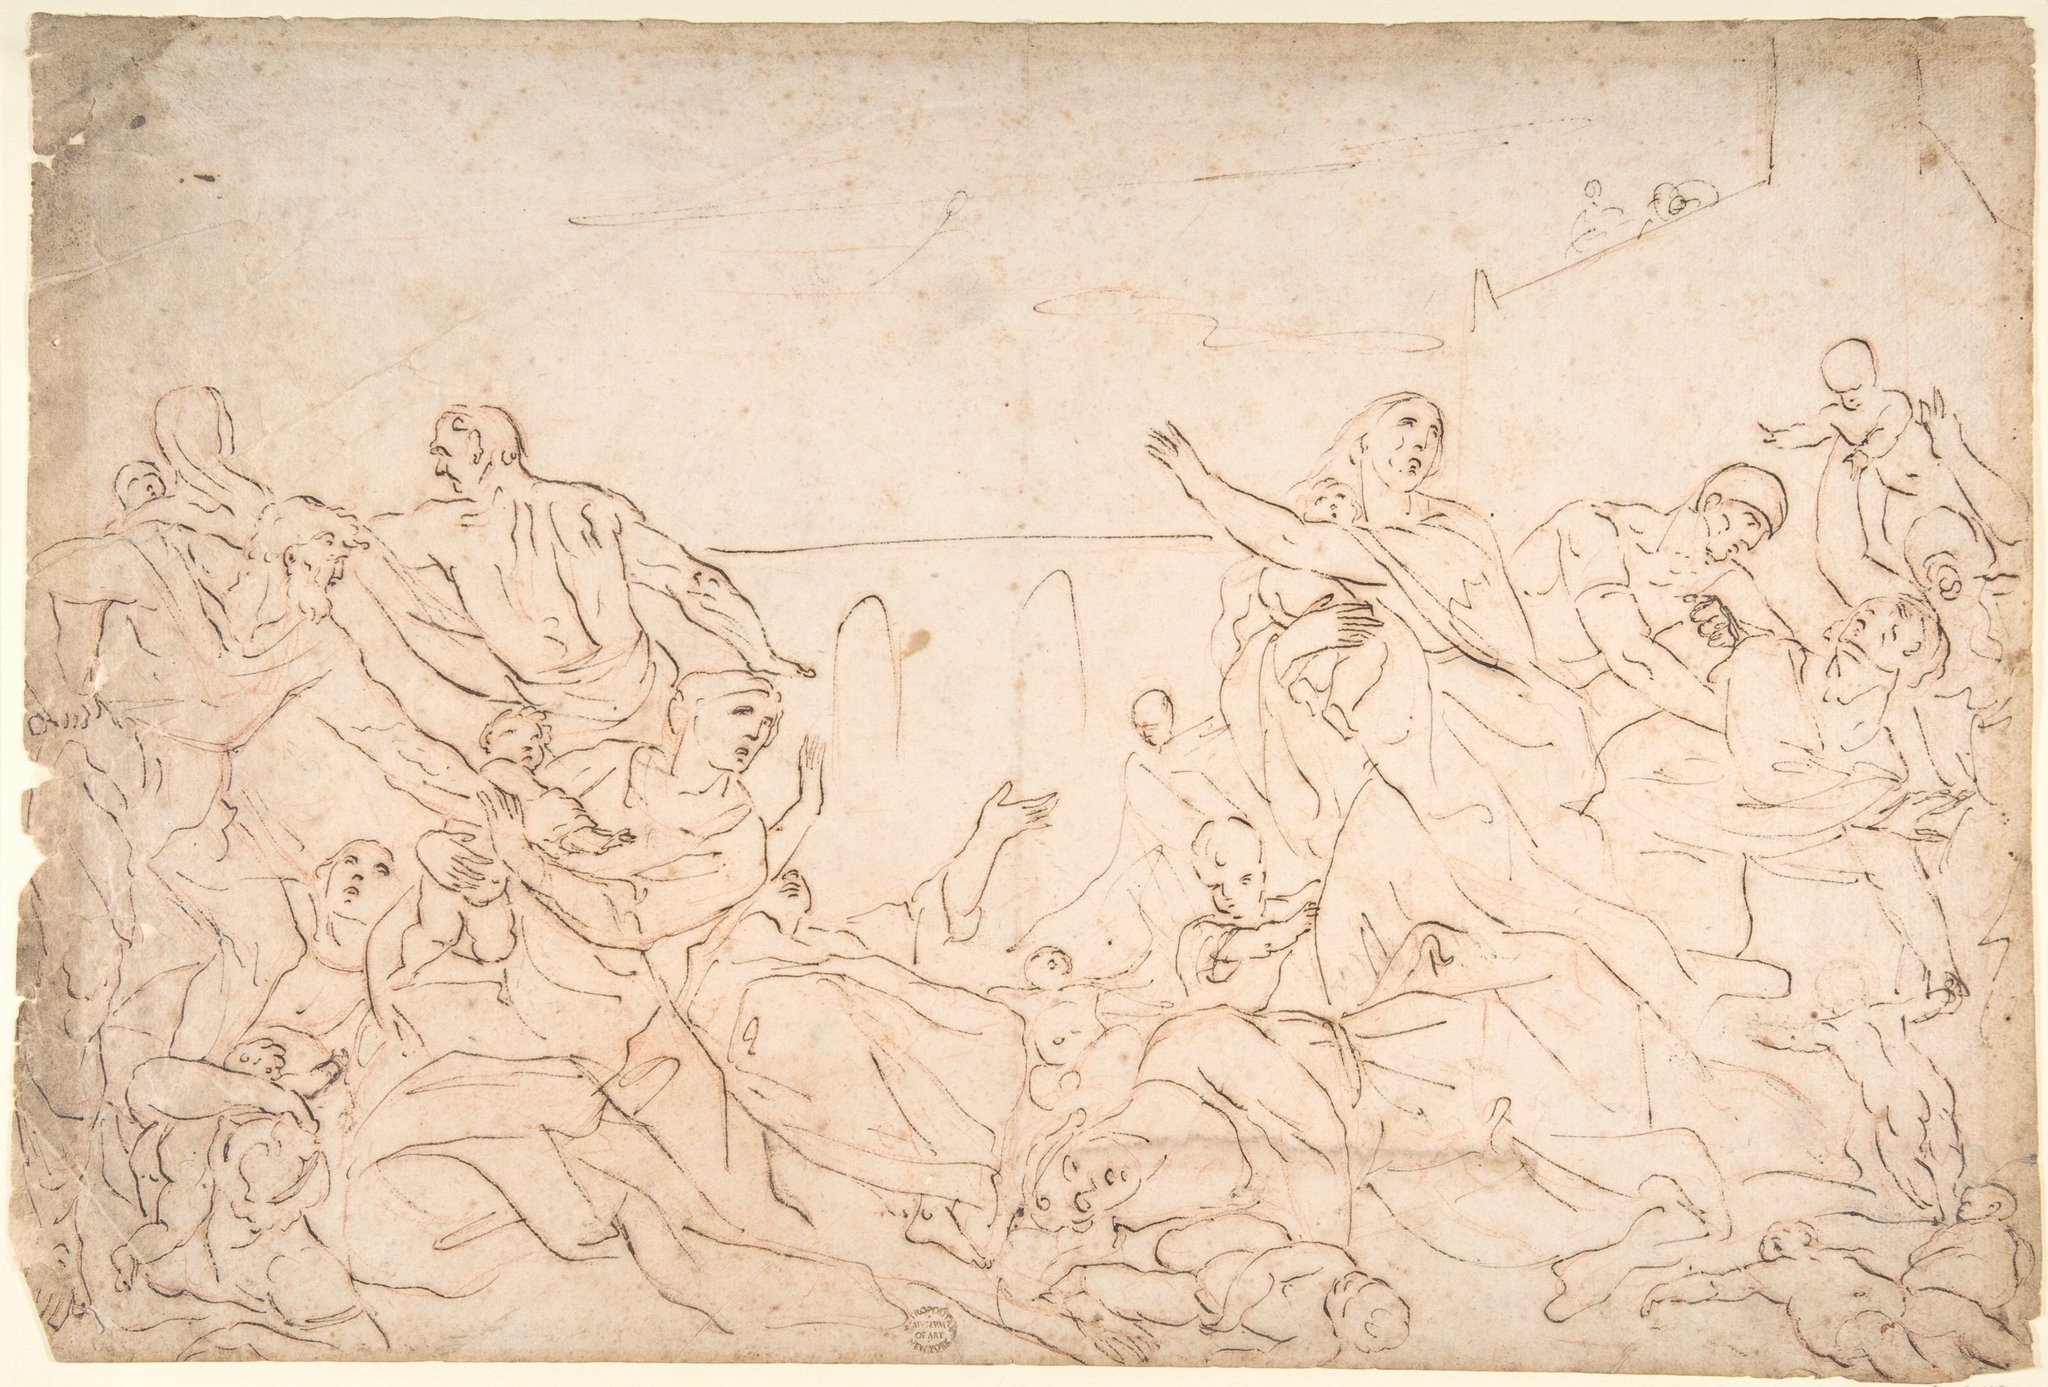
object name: drawing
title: Massacre of the Innocents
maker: anonymous, italian, 16th century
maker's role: artist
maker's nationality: italian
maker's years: 1550-1600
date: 1501-1600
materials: chalk, ink, paper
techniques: pen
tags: massacres